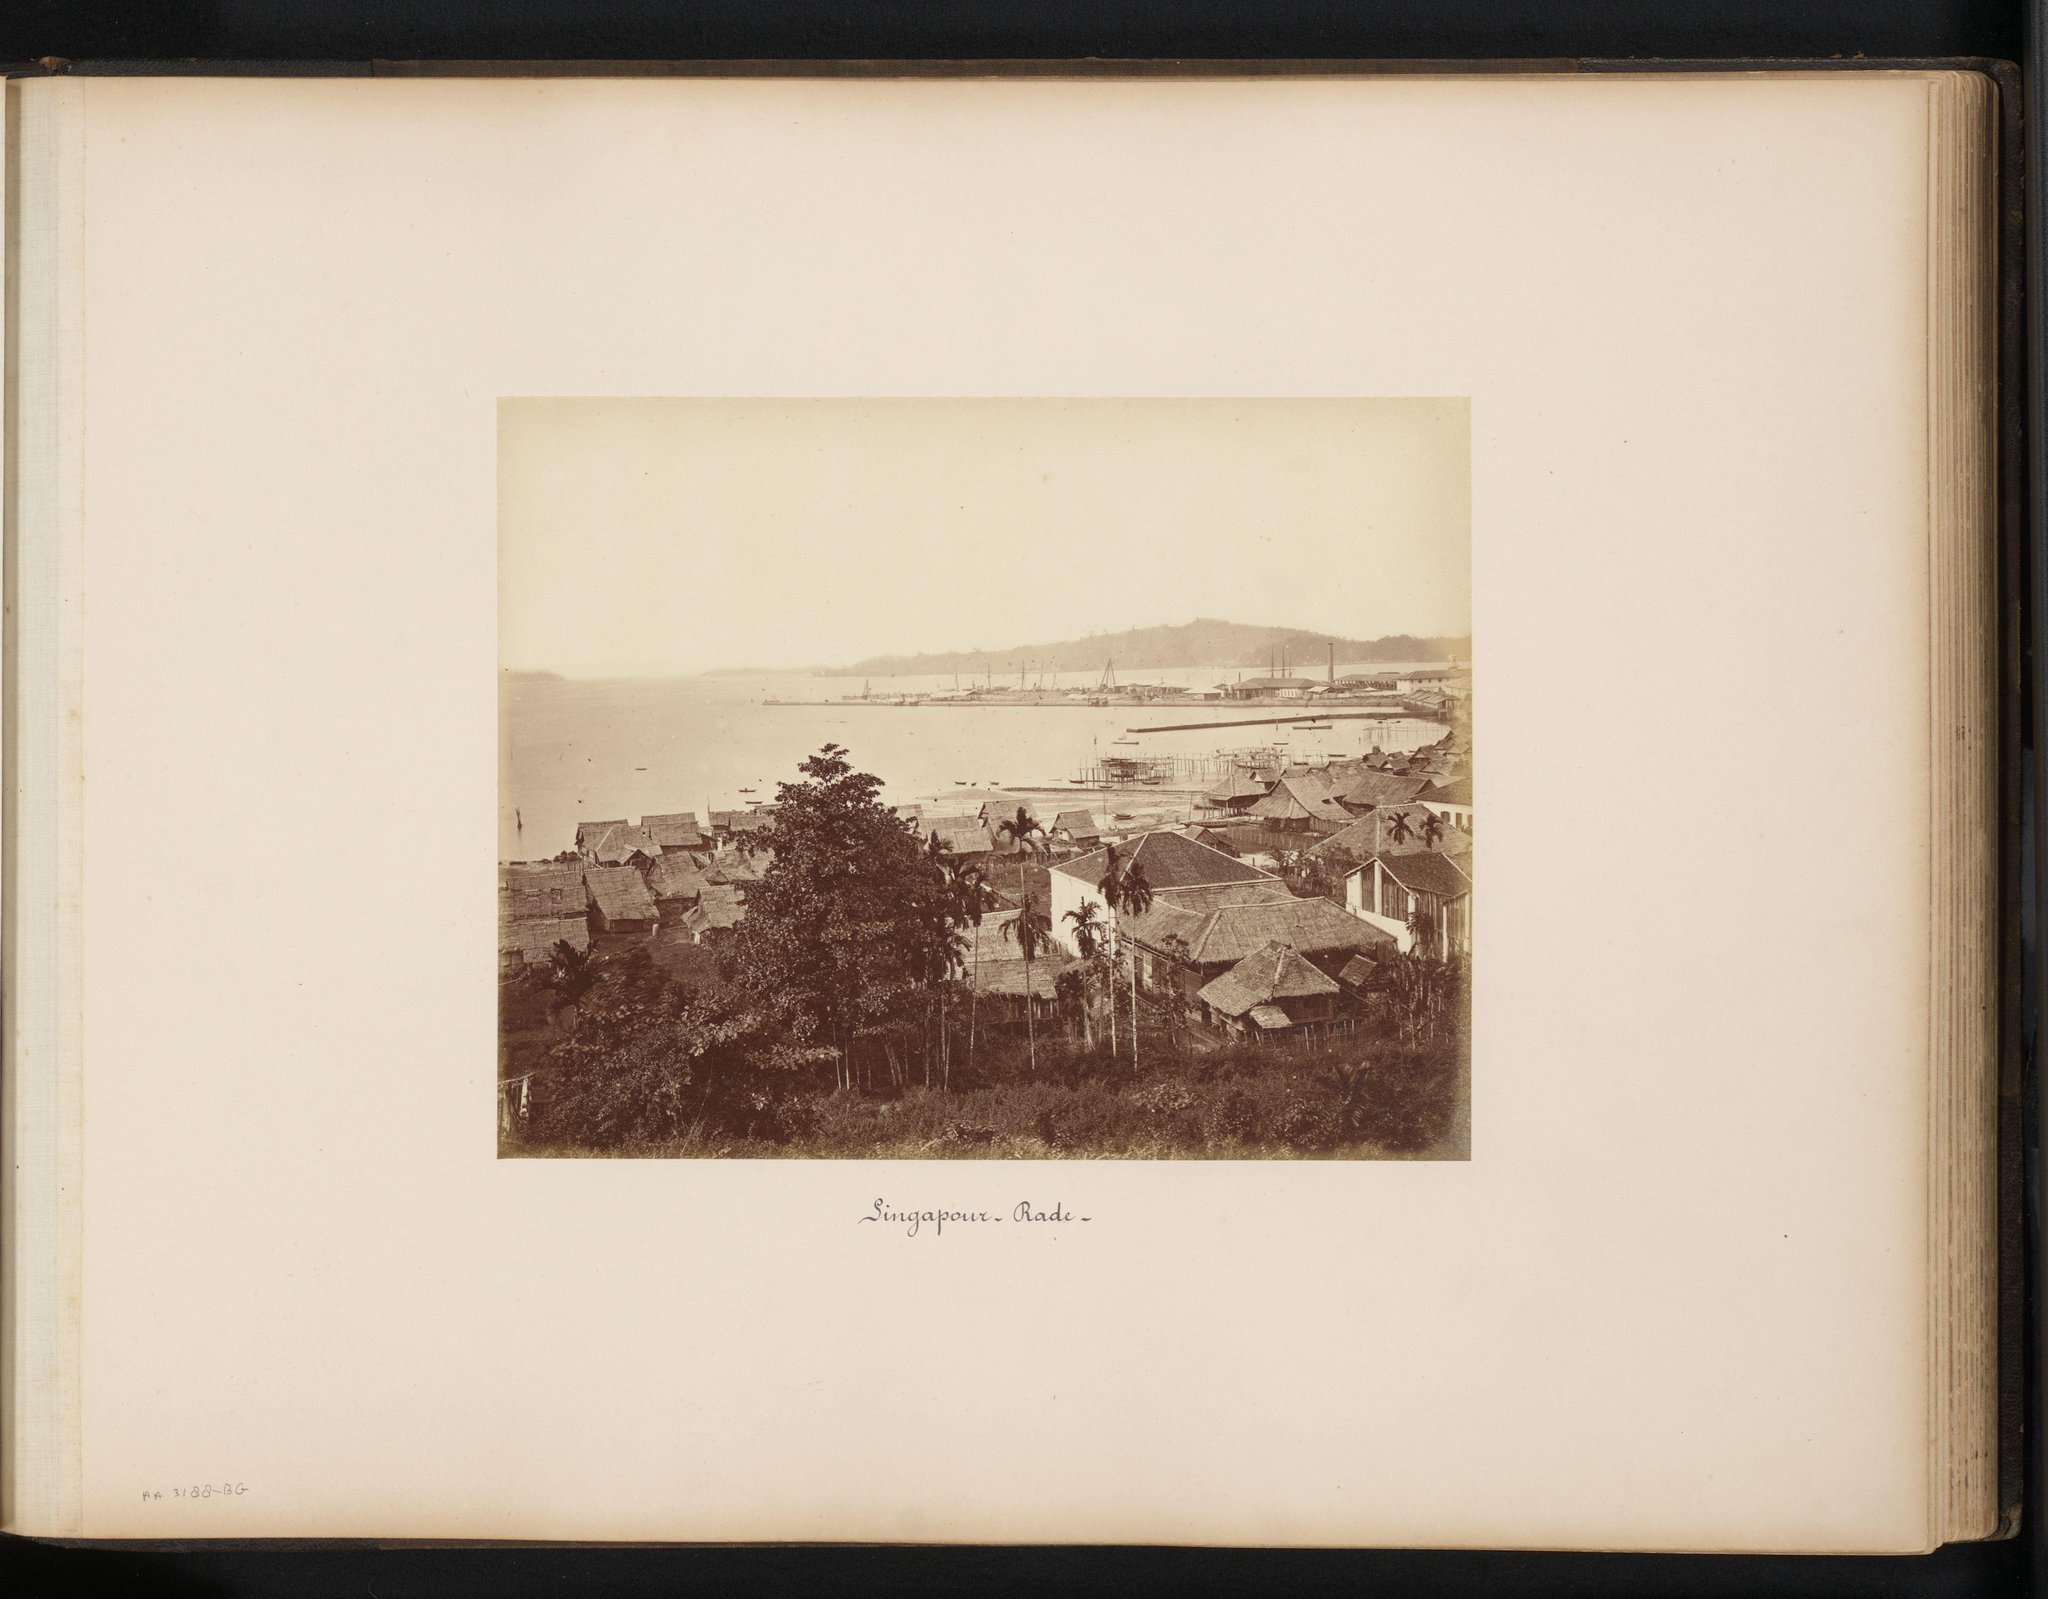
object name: photograph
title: View of the roadstead of Singapore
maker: Anonymous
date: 1880-1883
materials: photographic support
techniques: albumen print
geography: singapore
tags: harbour (+ view ~ vehicle, ship, etc.), singapore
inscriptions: title: ‘Singapour _ Rade _’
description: Onderdeel van Reisalbum met opnames van bezienswaardigheden in Egypte, Nederlands-Indië, Singapore en Ceylon.